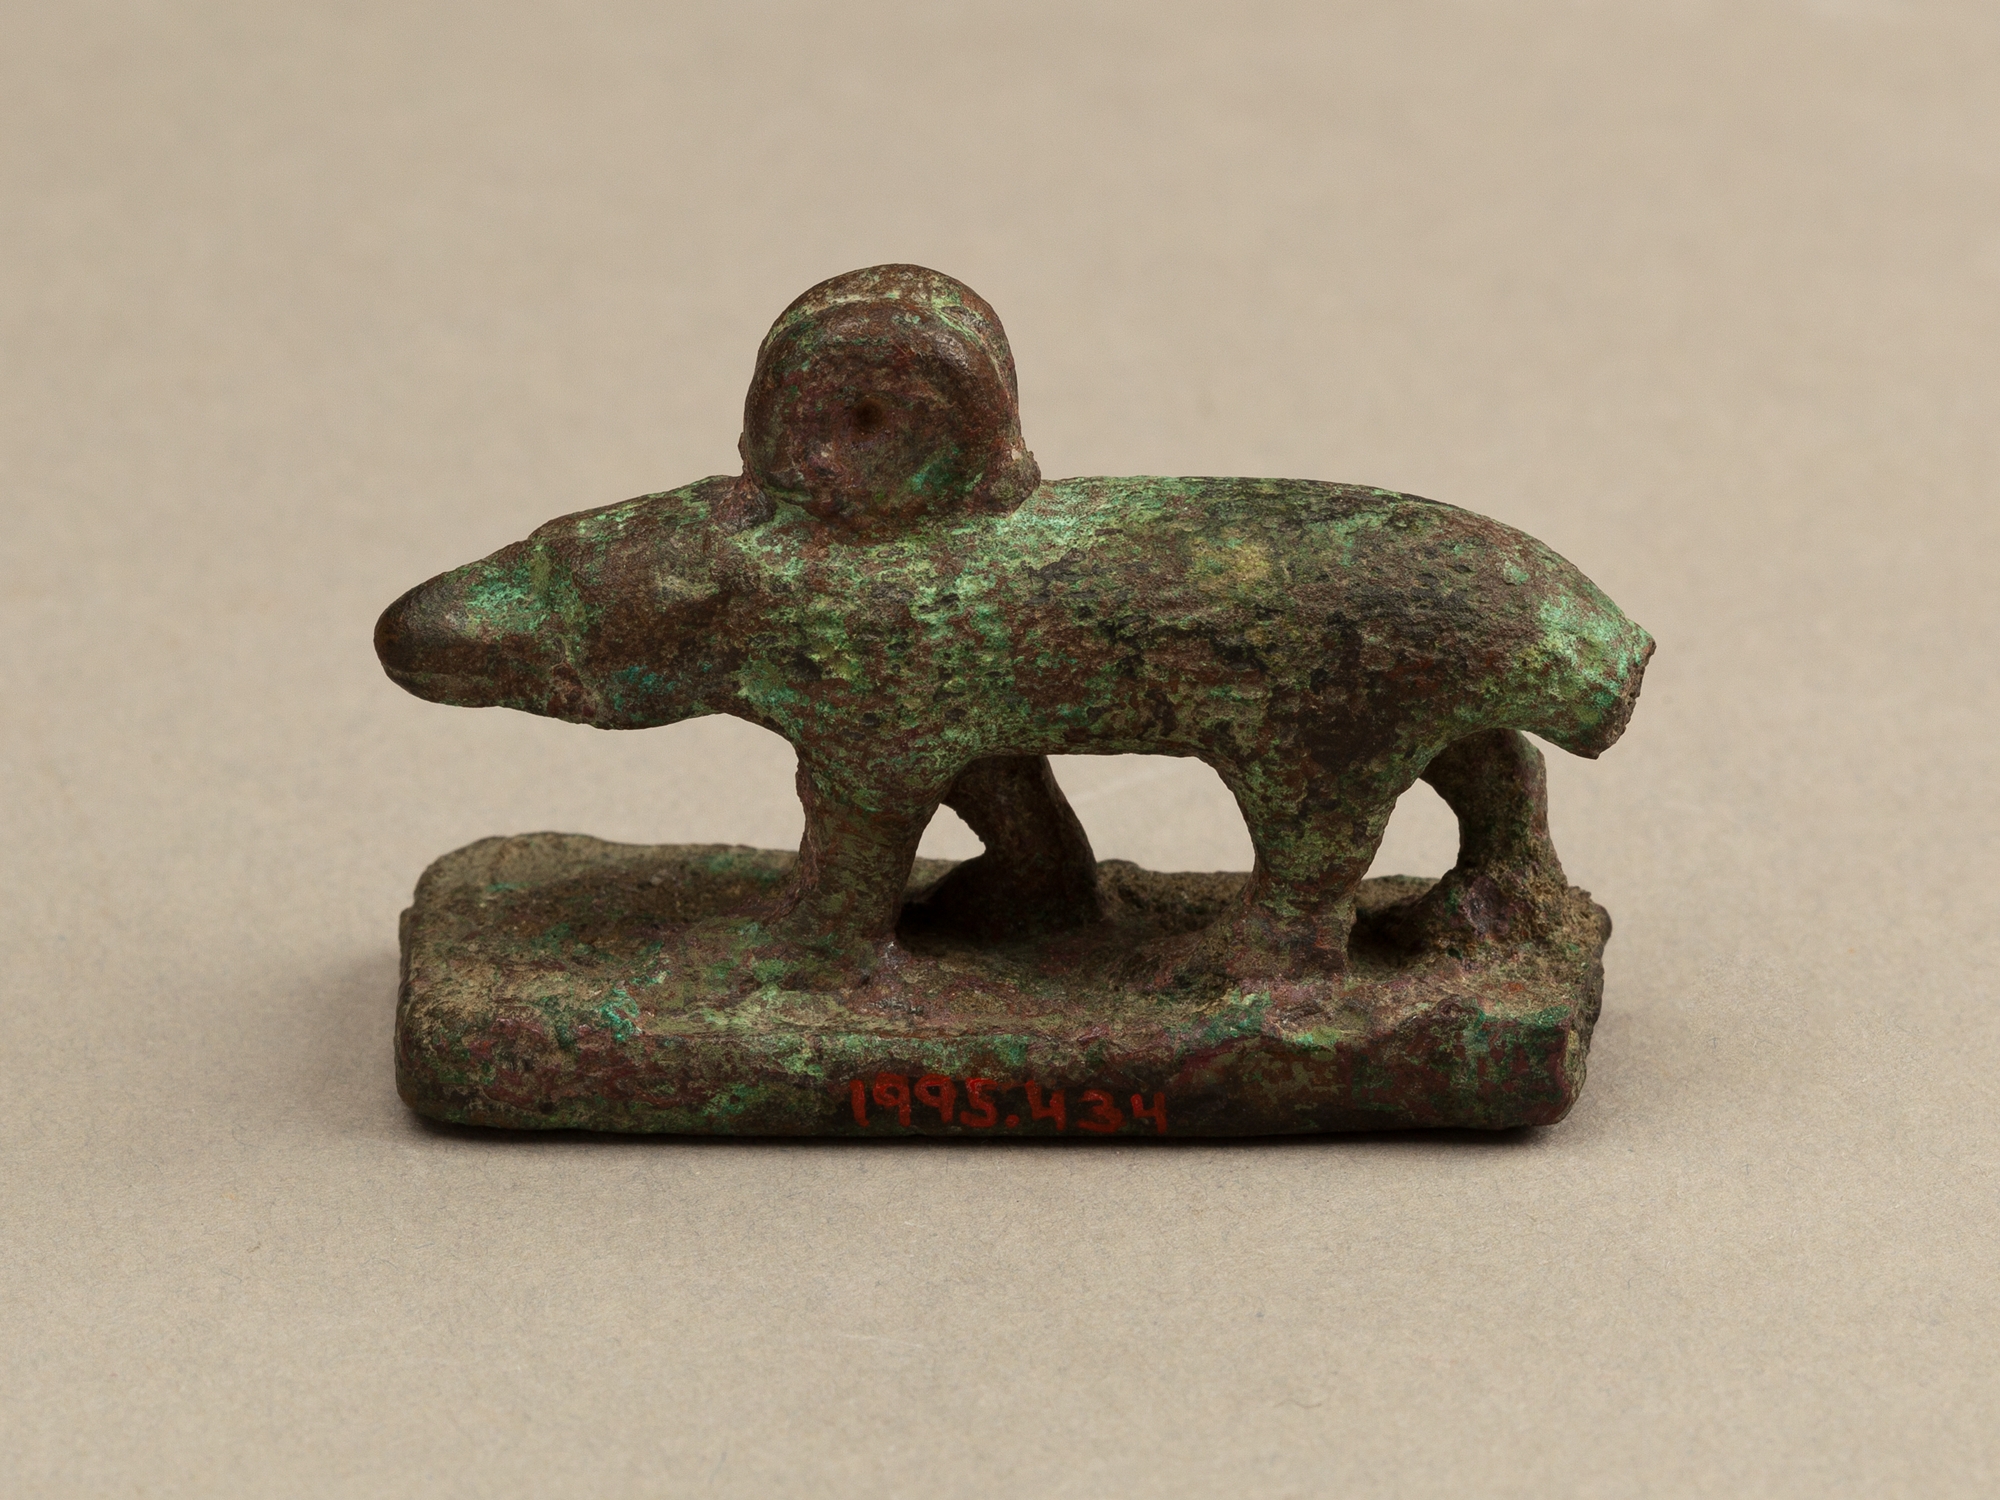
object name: pendant, ichneumon, inscribed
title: Figurine Pendant of an Ichneumon, inscribed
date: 332-330 BCE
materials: metal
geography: egypt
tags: animals